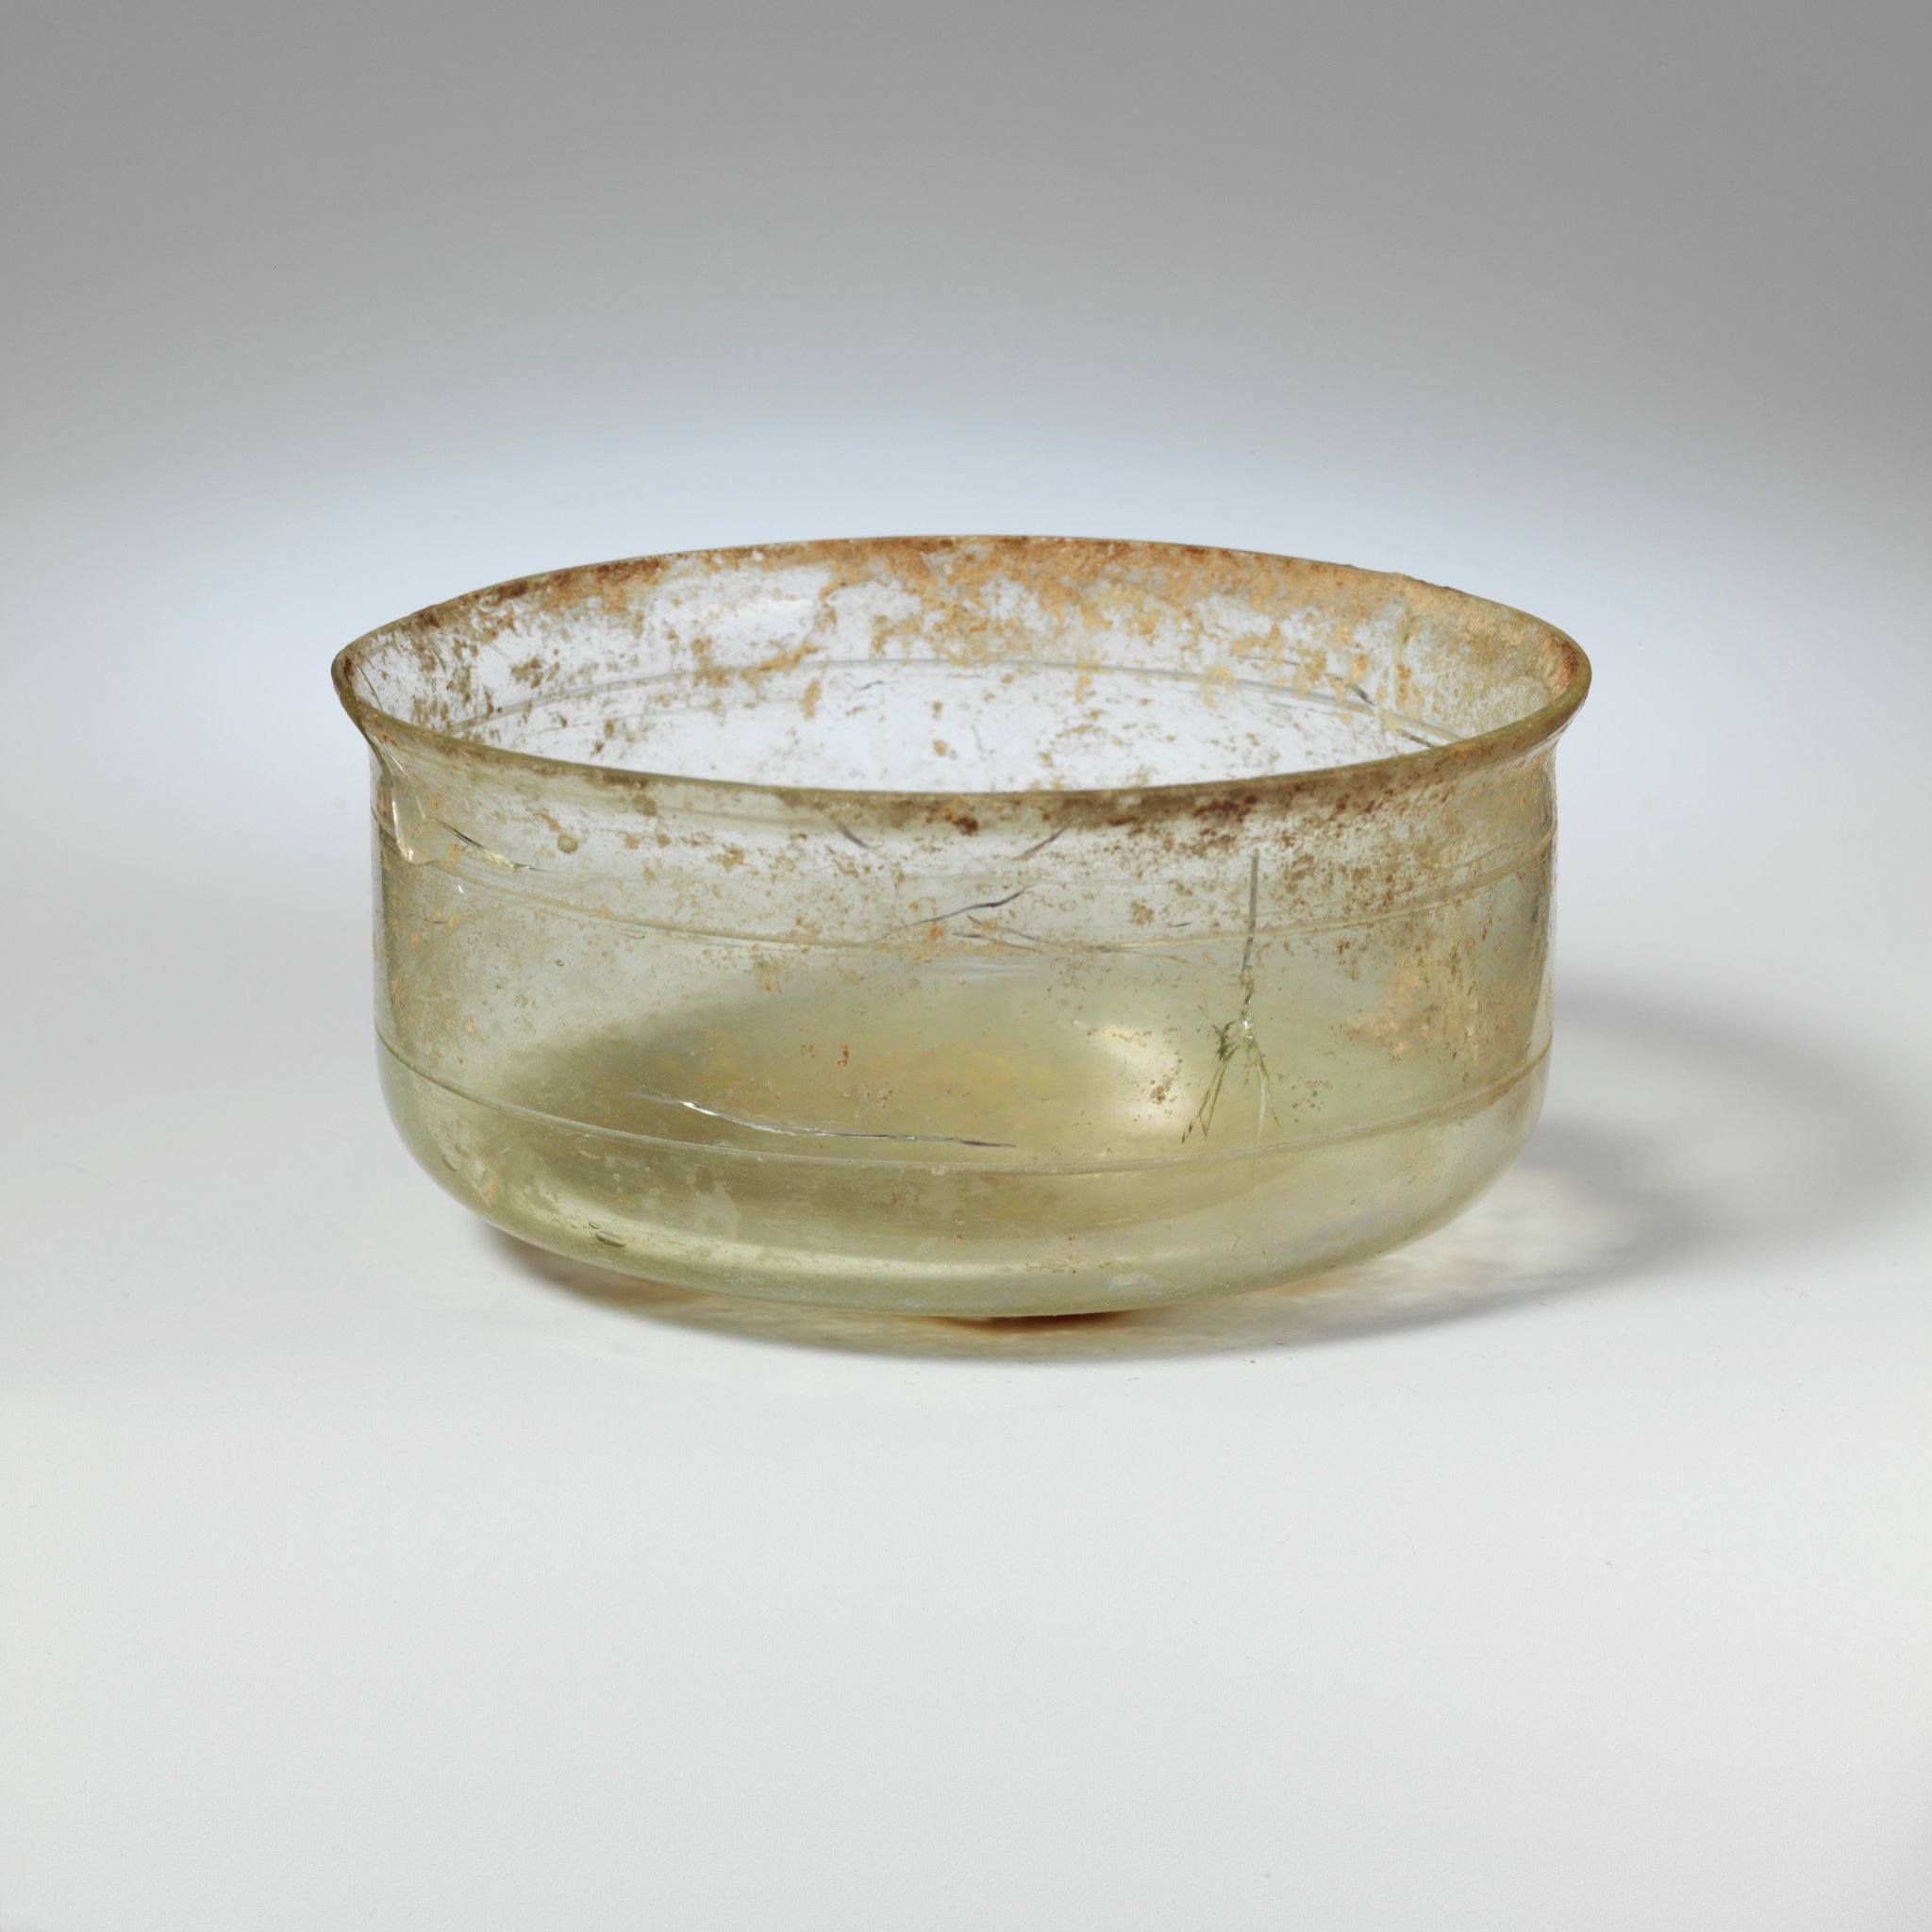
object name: bowl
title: Glass bowl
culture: roman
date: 34-200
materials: glass